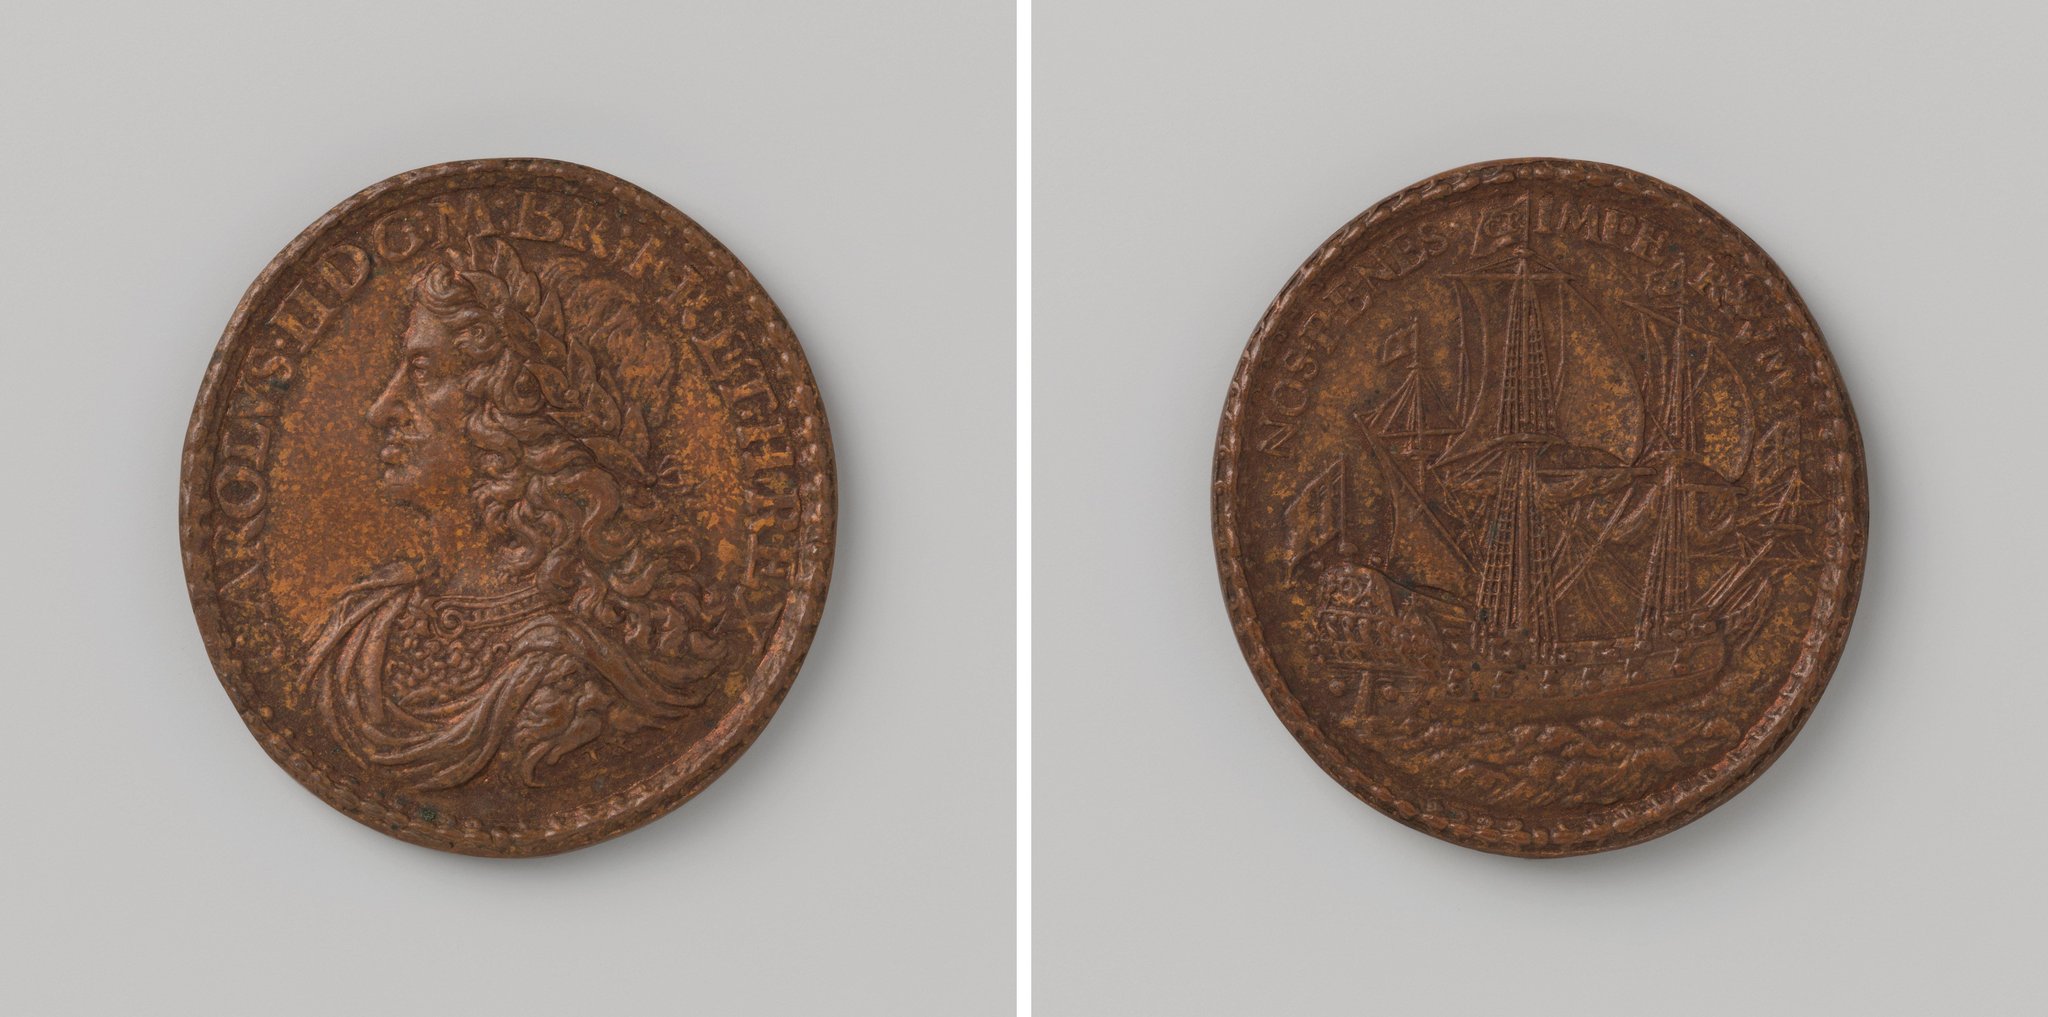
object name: copy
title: Karel II, koning van Engeland, heerser over de zee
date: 1665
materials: bronze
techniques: striking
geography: london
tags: karel ii (koning van engeland)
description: Bronzen ovale penning. Voorzijde: borststuk man met lauwerkrans binnen omschrift. Keerzijde: schip op zee binnen omschrift en sierrand